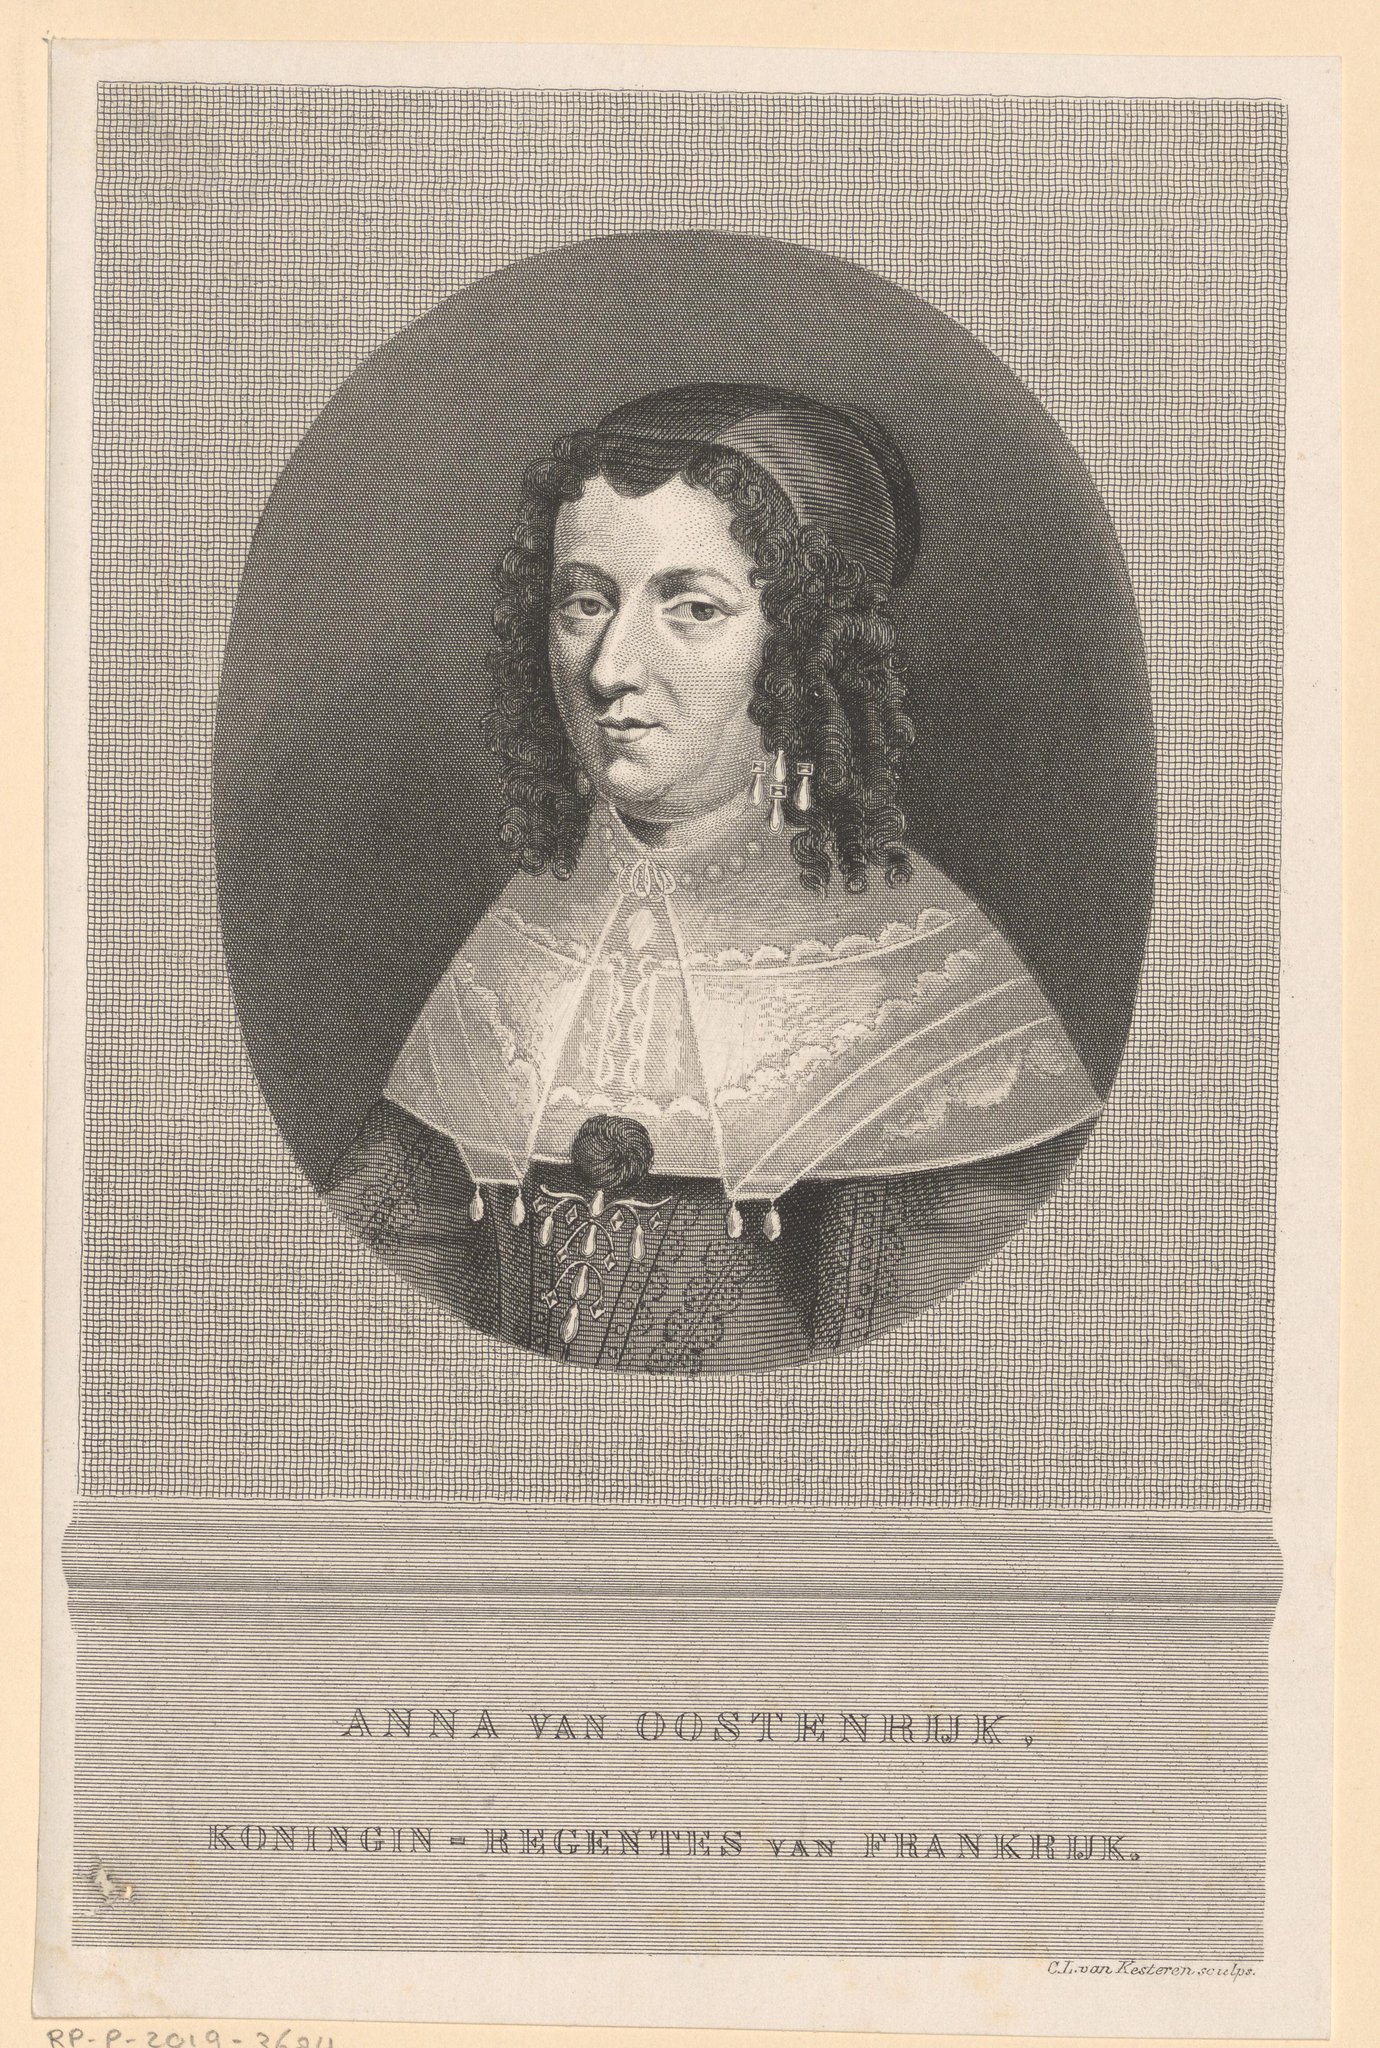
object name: print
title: Portret van Anna van Oostenrijk, koningin van Frankrijk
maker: christiaan lodewijk van kesteren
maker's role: print maker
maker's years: 1832-1897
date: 1877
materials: paper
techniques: engraving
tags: anna van oostenrijk (koningin van frankrijk), historical persons - bb - woman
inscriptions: inscription: ‘No 545’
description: Prent uit: Arend, Johannes Pieter. Algemeene geschiedenis des vaderlands (...). 4 dln. Amsterdam, Leiden en Haarlem: 1841-1879, dl. 4.1 (1877).